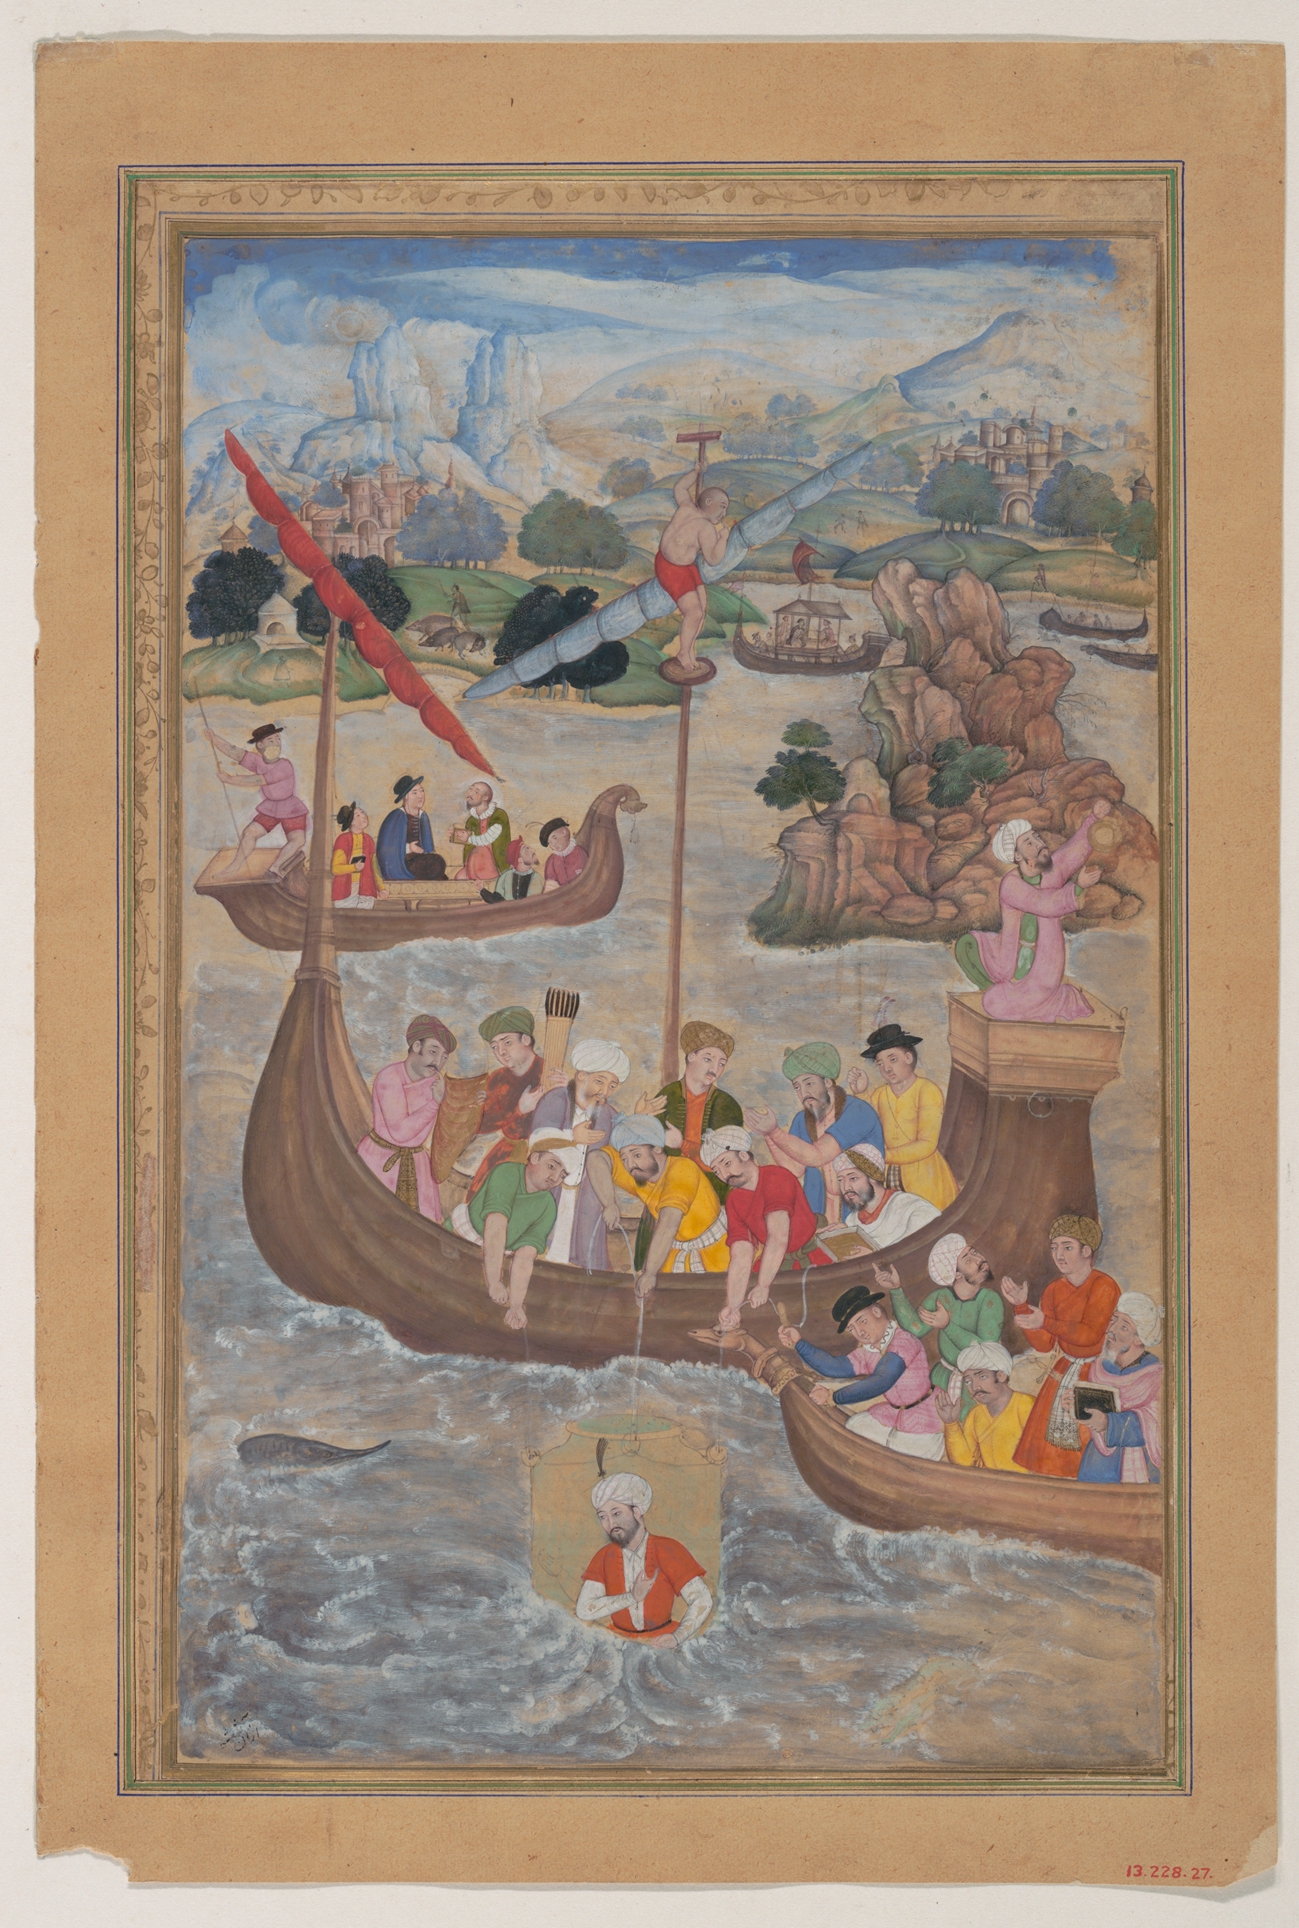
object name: folio from an illustrated manuscript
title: "Alexander is Lowered into the Sea", Folio from a Khamsa (Quintet) of Amir Khusrau Dihlavi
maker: amir khusrau dihlavi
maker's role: author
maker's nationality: indian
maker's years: 1228-1350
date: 1597-1598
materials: gold, ink, paper, watercolor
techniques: dyeing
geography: india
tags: alexander the great,men,boats